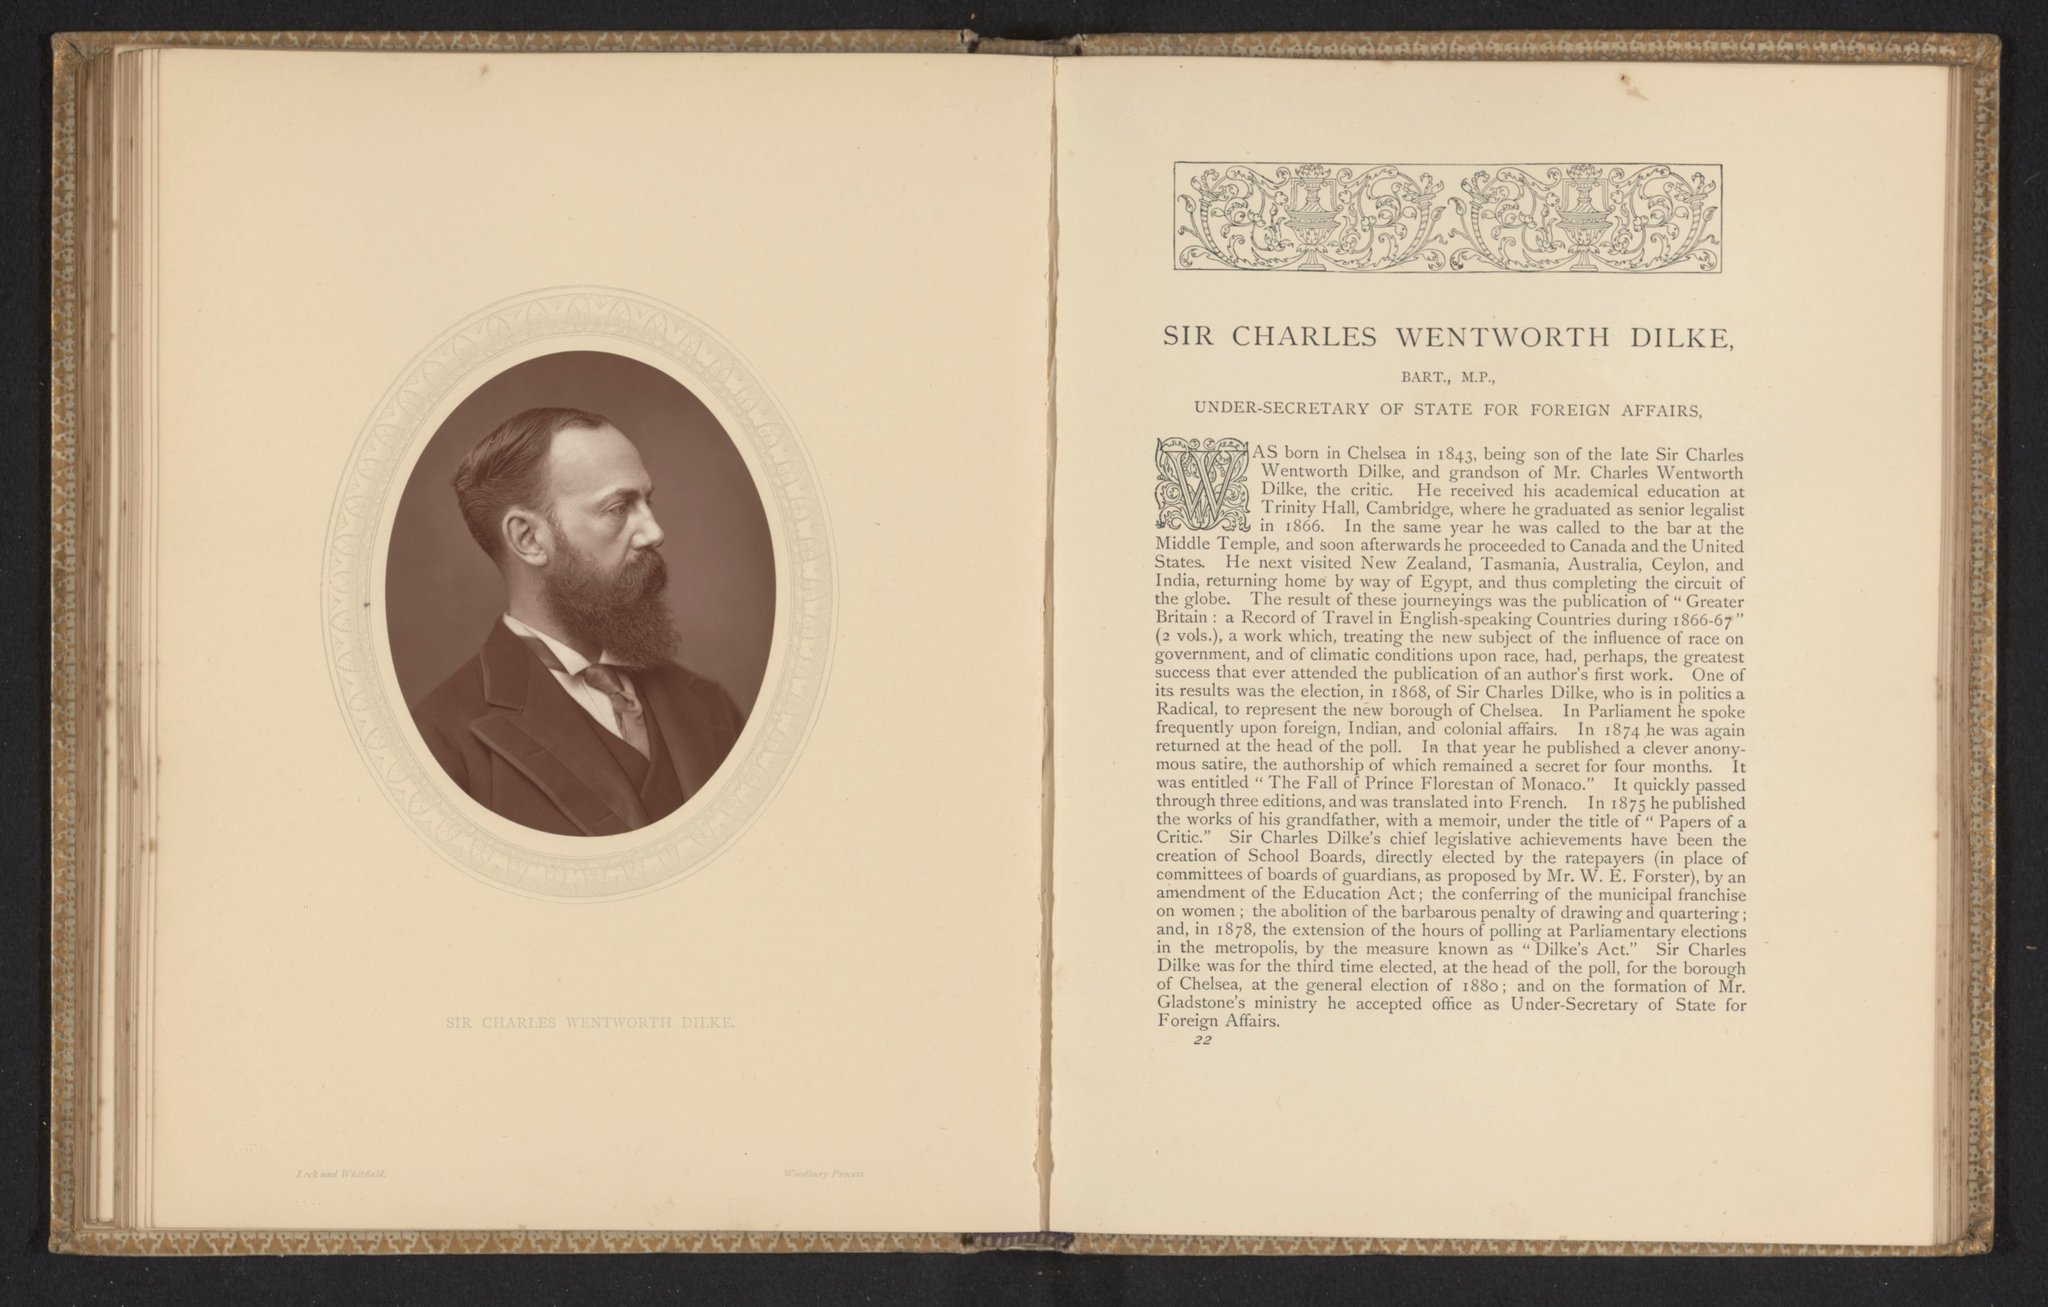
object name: photomechanical print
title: Sir Charles Wentworth Dilke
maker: Anonymous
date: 1876-1881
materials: paper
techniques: woodburytype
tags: historical persons (portraits and scenes from the life) (+ (full) bust portrait), politician, e.g. party leader